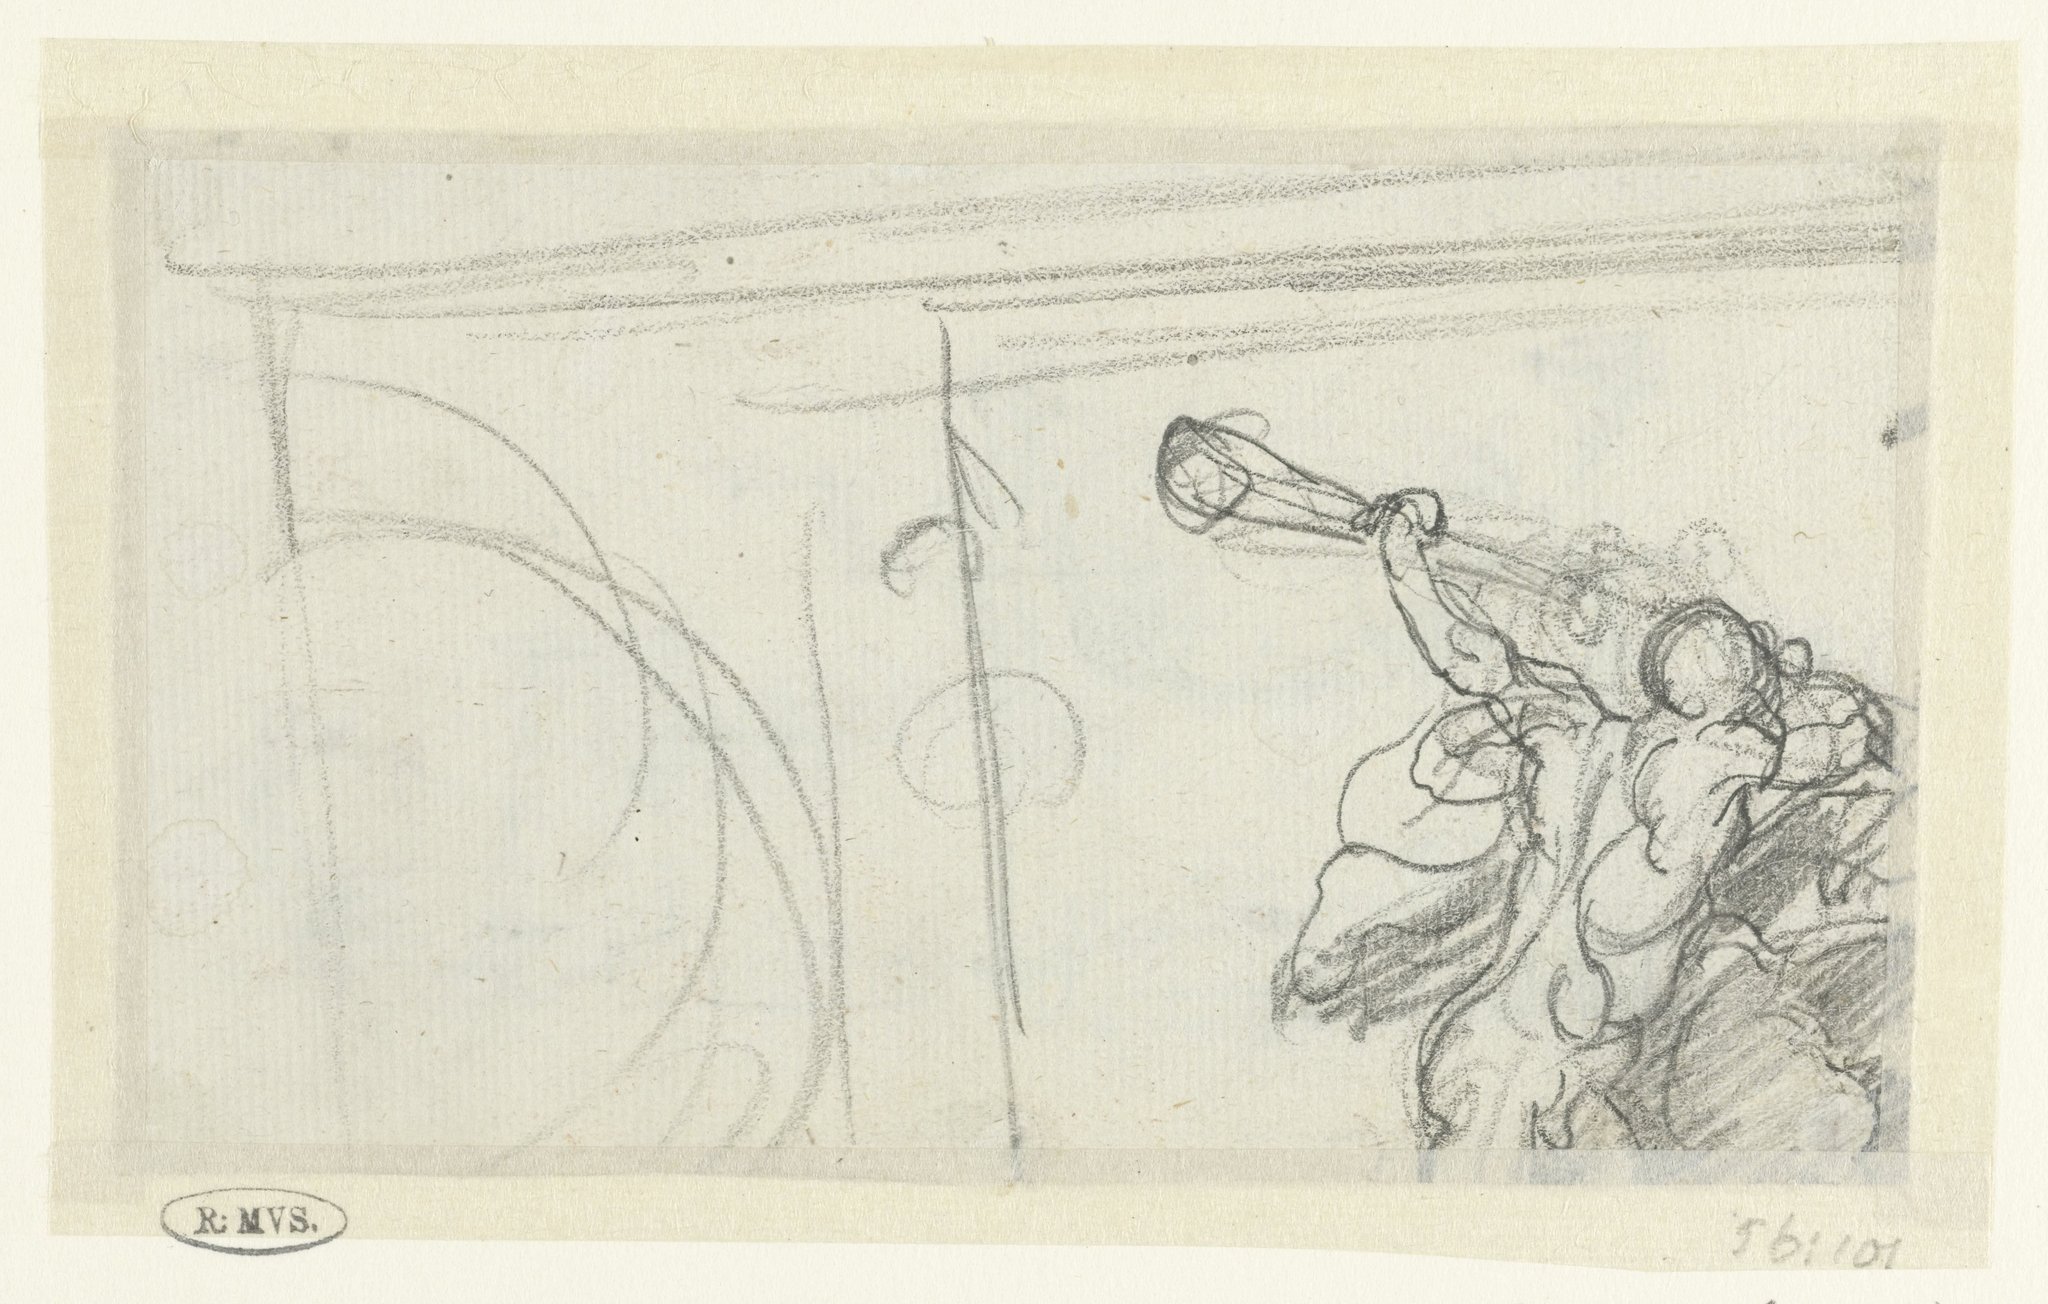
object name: drawing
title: Schets naar een muurdecoratie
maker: etienne de lavallée-poussin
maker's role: draughtsman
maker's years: 1733-1793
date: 1750-1793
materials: paper, pencil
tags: wall-covering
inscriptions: collector's mark, lower left: Lugt 2228